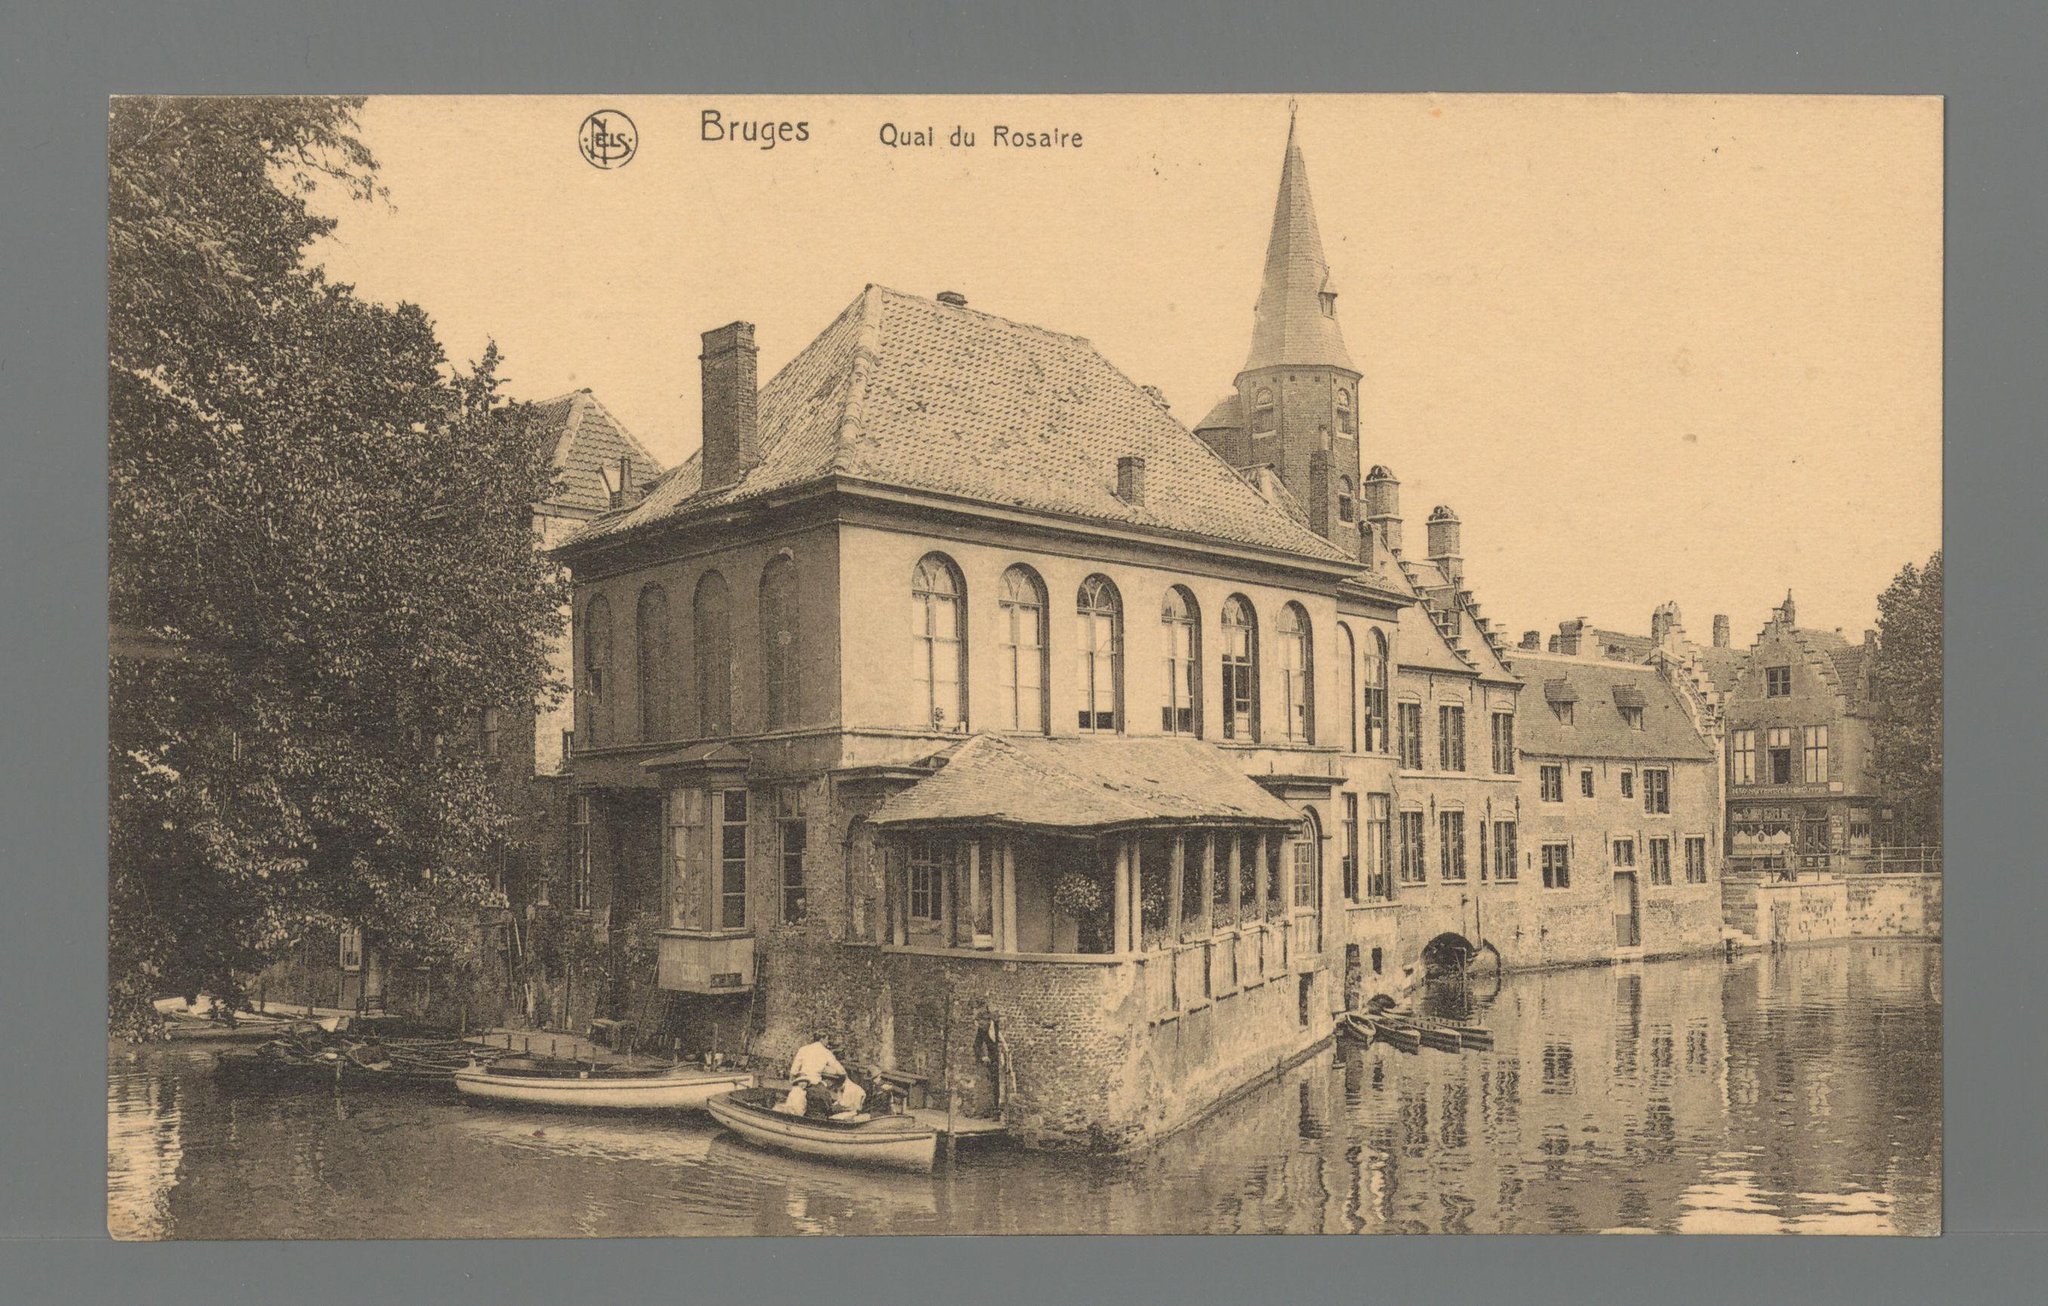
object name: ansichtkaart, prentbriefkaart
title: Bruges. Quai du Rosaire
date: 1913-1930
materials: cardboard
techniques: photograph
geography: brussels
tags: canal, rowing-boat, canoe, etc., city-view, and landscape with man-made constructions (+ city(-scape) with figures, staffage), bruges